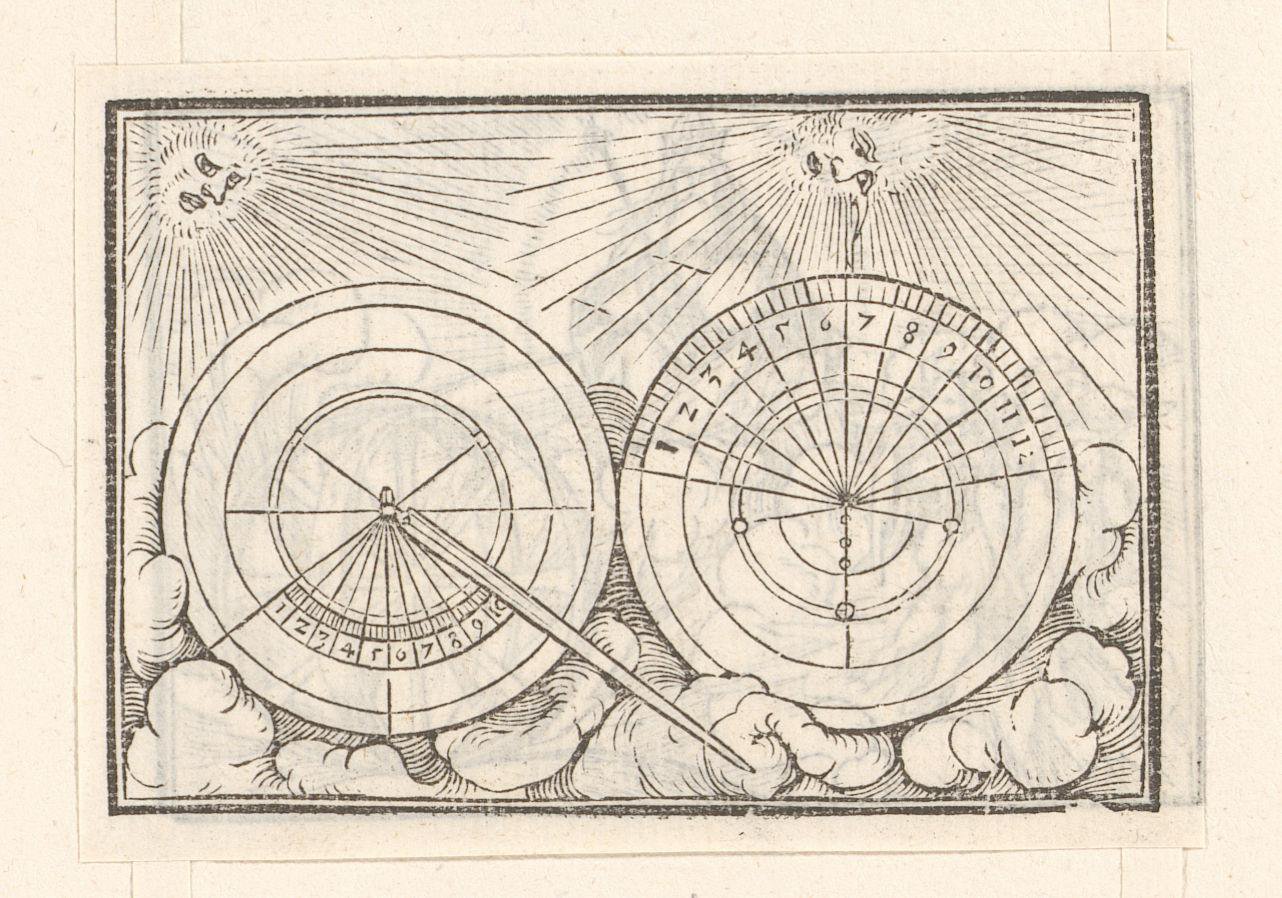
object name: print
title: Schaduw op zonnewijzer teruggezet voor Hizkia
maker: veit rudolf specklin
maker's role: print maker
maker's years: -1550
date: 1538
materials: paper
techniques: woodcut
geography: switzerland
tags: isaiah prays to god and the shadow of the sundial goes back ten degrees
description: God geeft koning Hizkia een teken dat hij zijn gebed om langer te mogen leven heeft gehoord, hij laat de schaduw op de zonnewijzer tien graden achteruitgaan. Twee zonnewijzers zijn naast elkaar weergegeven met twee verschillende standen van de zon. Rechts is mogelijk het huilende gezicht van de koning in de zon weergegeven en links het gzicht van de profeet Jesaja. Prent maakt deel uit van een album.